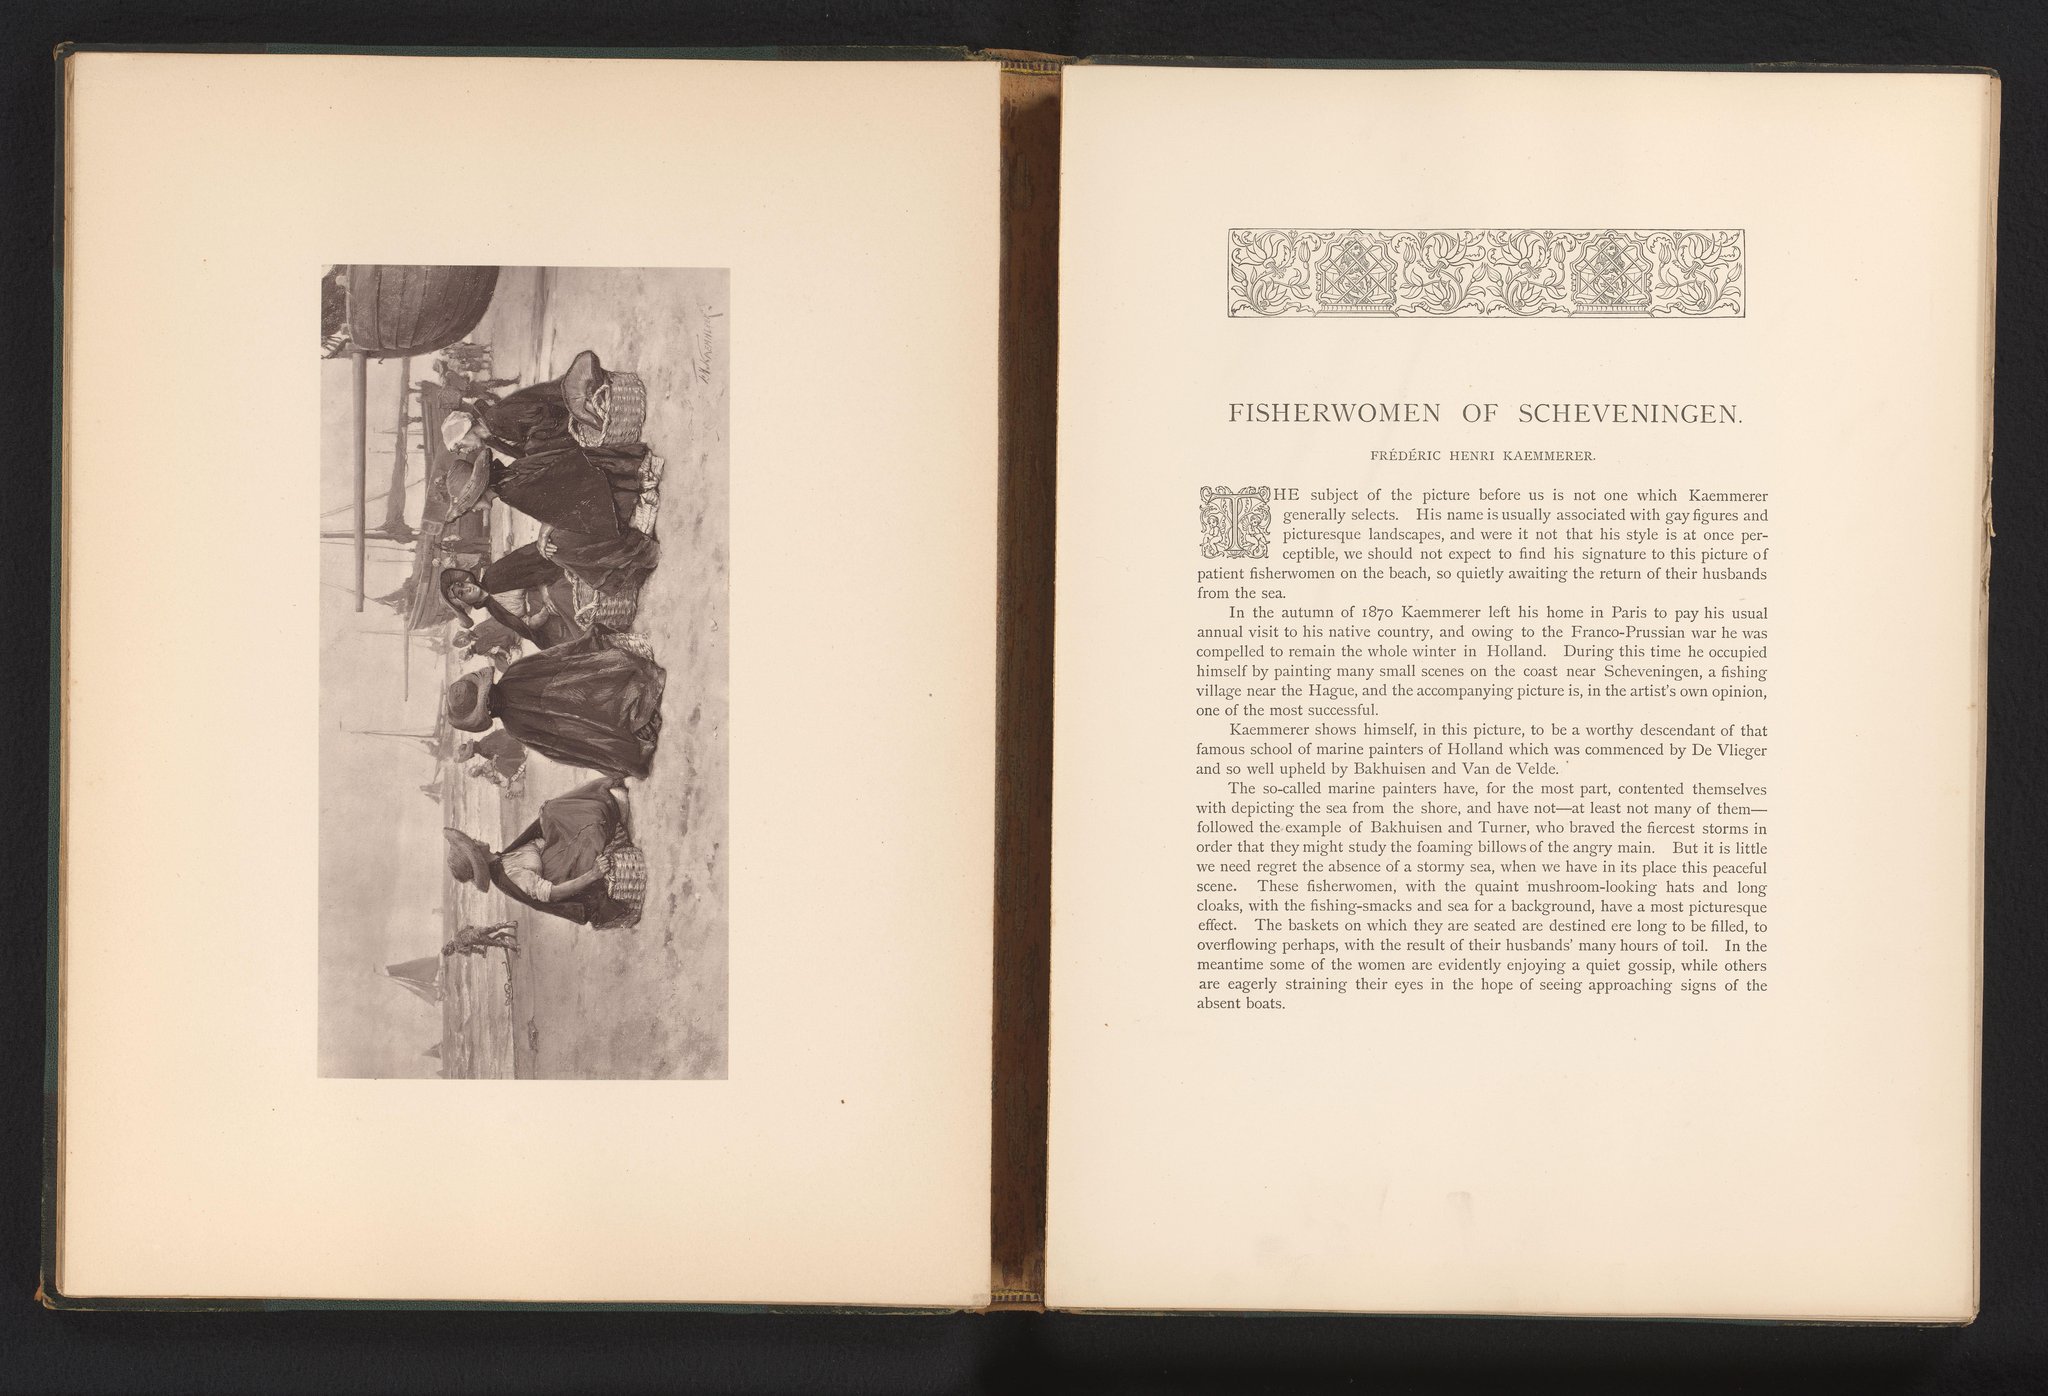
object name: page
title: Reproductie van een schilderij van een groep vissersvrouwen op het strand van Scheveningen door Frederik Hendrik Kaemmerer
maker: Anonymous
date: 1874-1879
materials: paper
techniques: woodburytype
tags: adolescent, young woman, maiden, beach